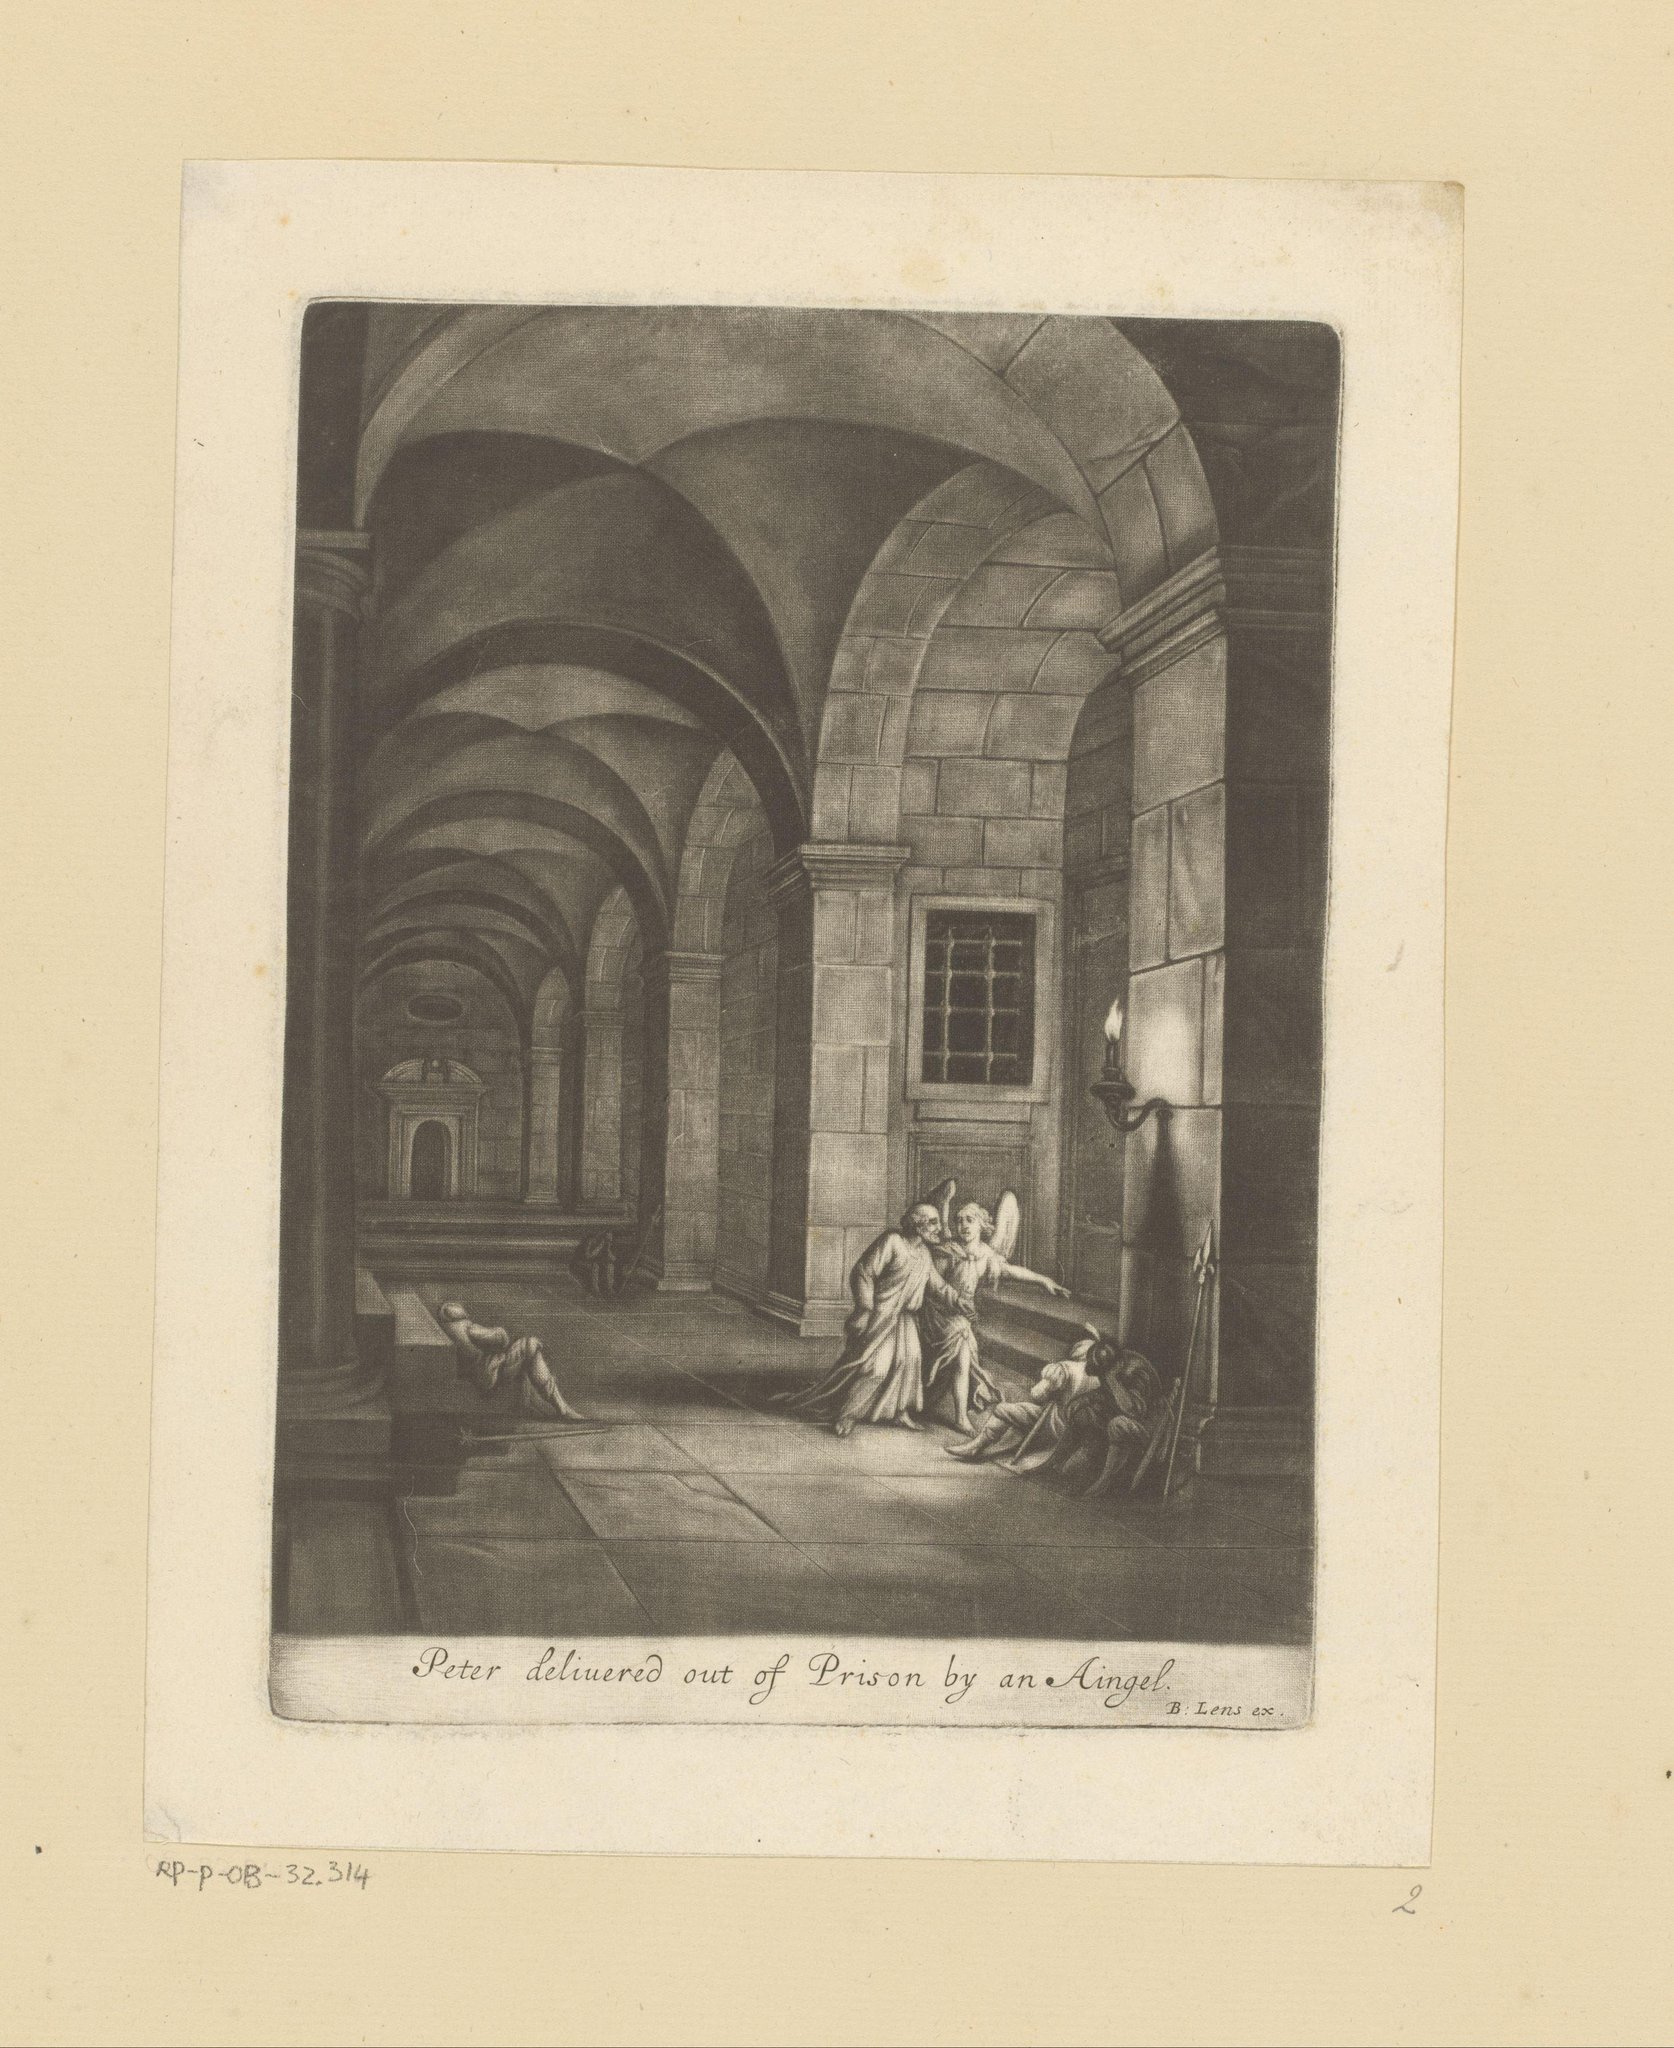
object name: print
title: Petrus wordt uit de gevangenis bevrijd door een engel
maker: bernard lens (ii)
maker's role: print maker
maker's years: 1659-1725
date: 1669-1725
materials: paper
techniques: etching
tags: prison, jail, an angel appears, summoning peter to wake up ~ peter in prison, the angel leads peter past the sleeping guards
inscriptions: collector's mark: Lugt 240